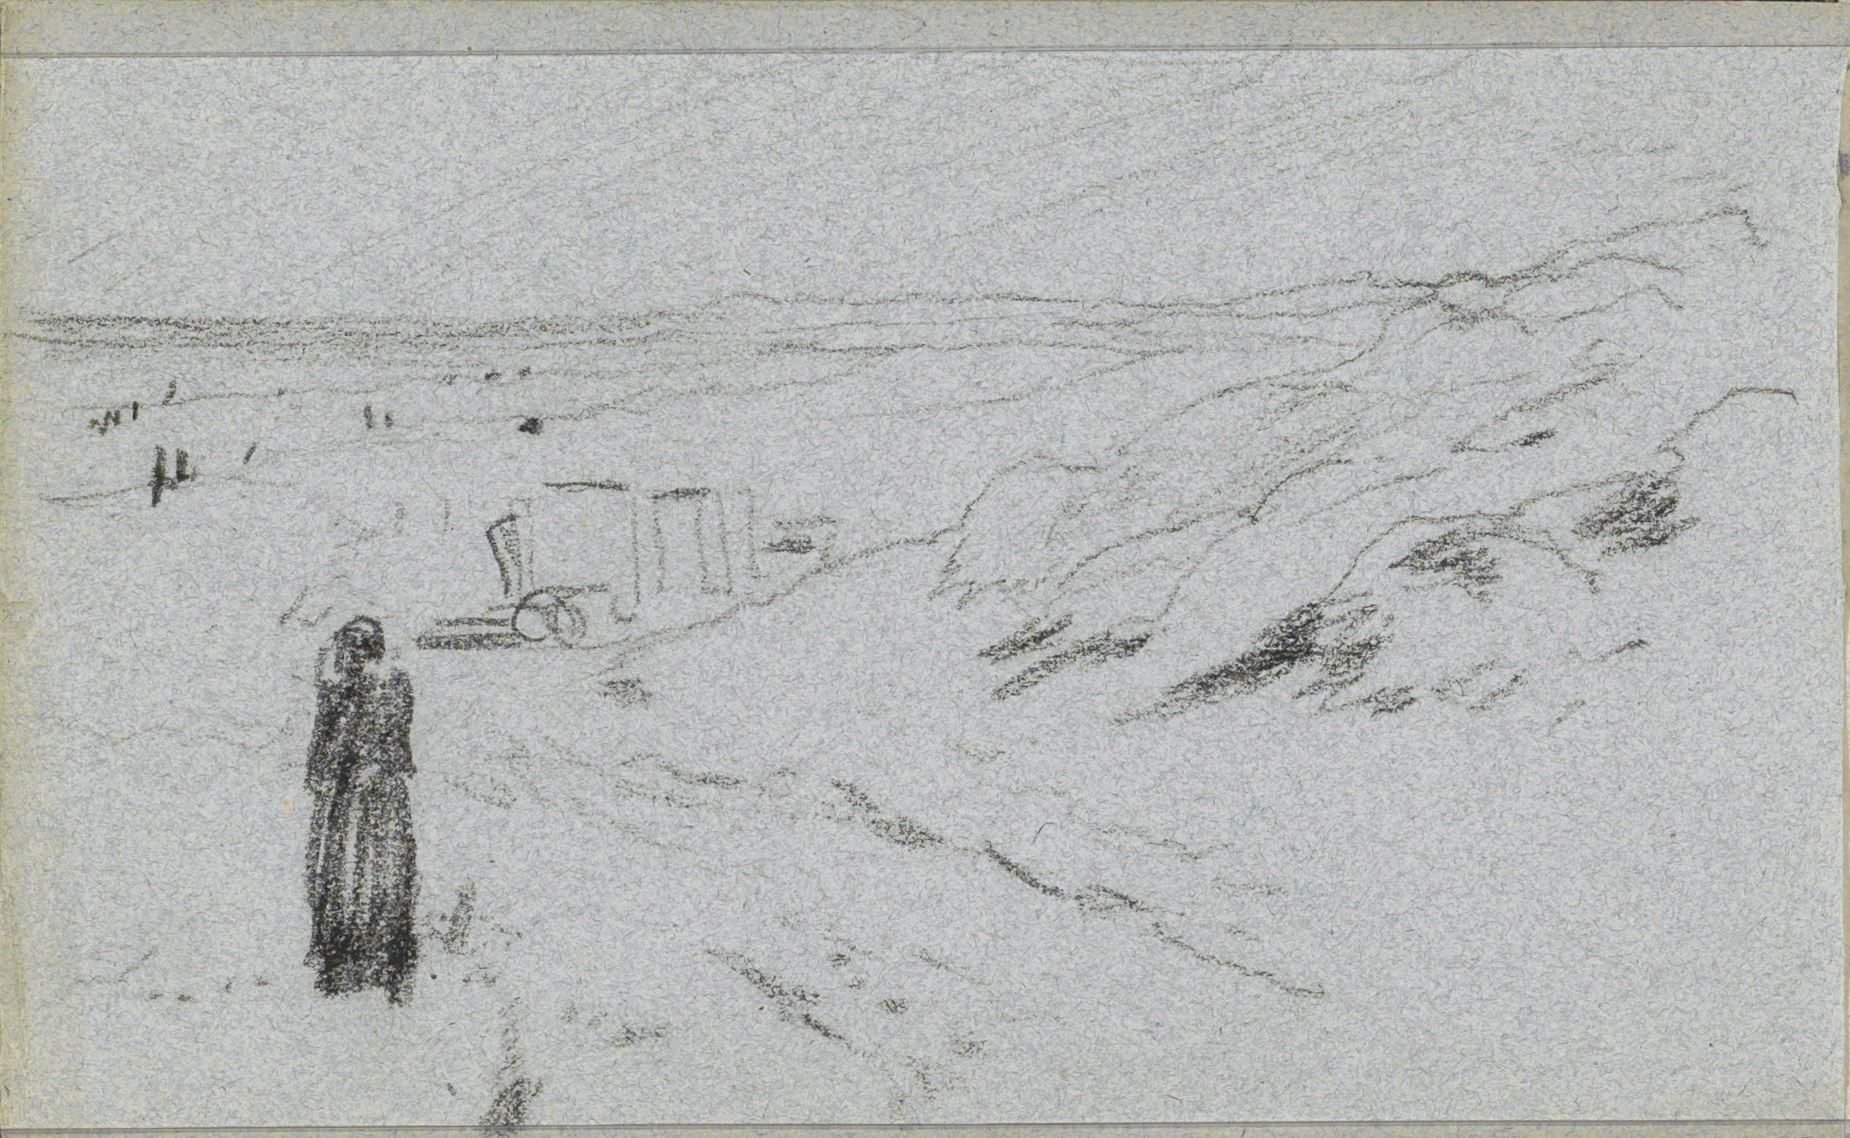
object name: sketchbook leaf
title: Figuur die een duinpad richting het strand afdaalt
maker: anton mauve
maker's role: draughtsman, painter, print maker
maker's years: 1838-1888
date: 1876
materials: chalk, paper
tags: dune coast (+ landscape with figures, staffage)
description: De compositie van de schets vertoont gelijkenissen met het schilderij 'Morgenrit langs het strand' uit 1876.